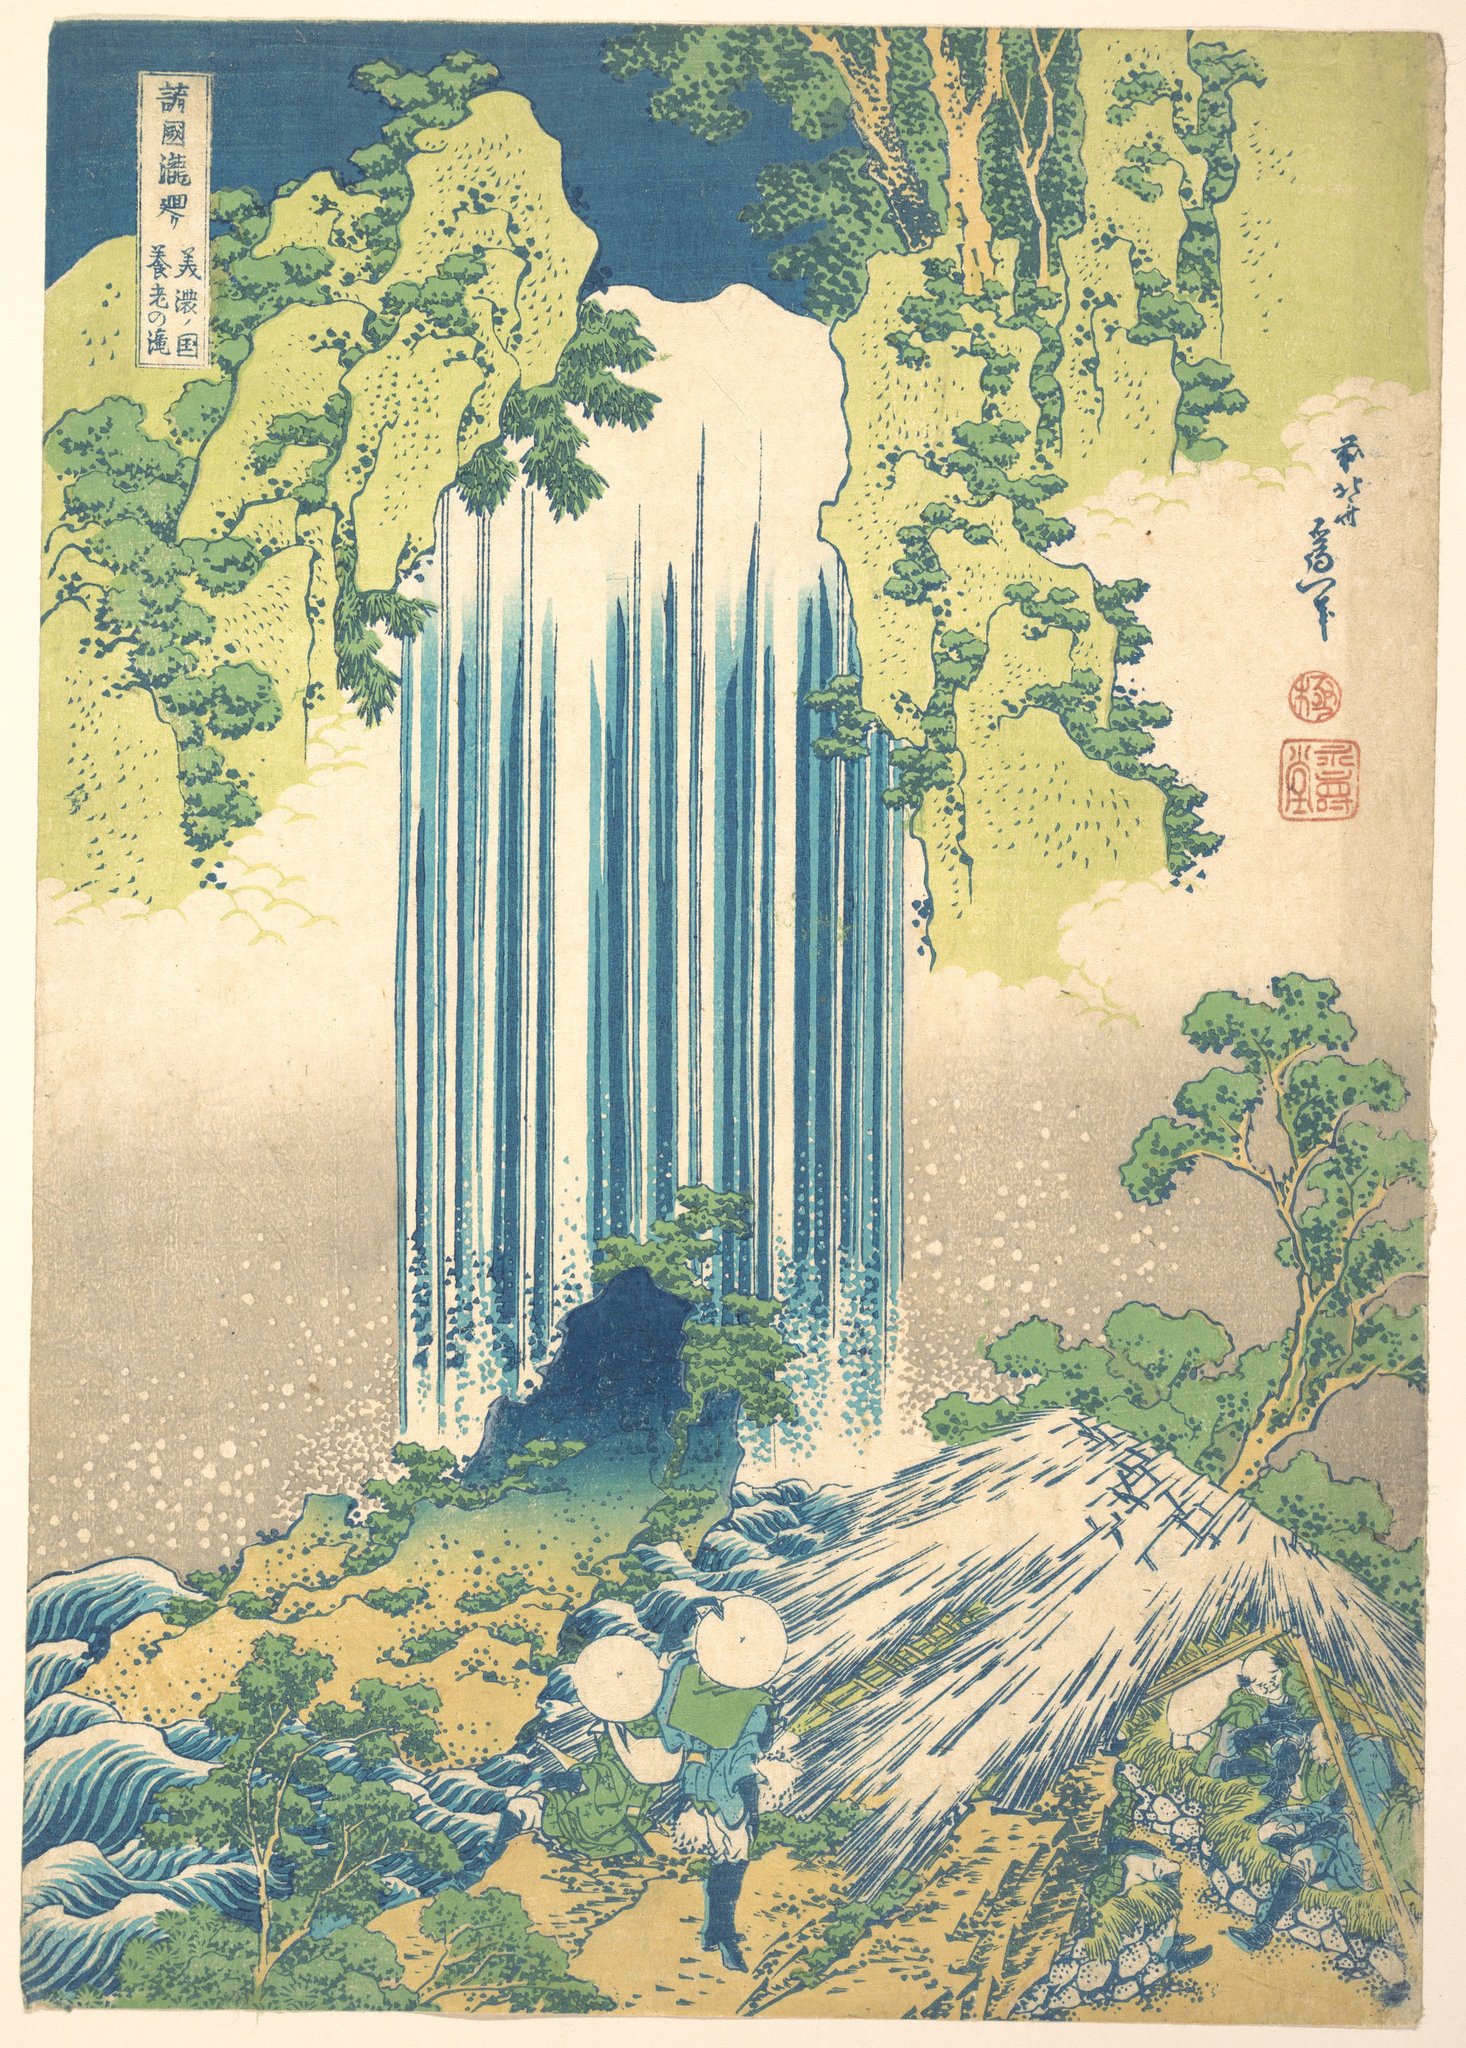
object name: woodblock print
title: Yōrō Waterfall in Mino Province (Mino no Yōrō no taki), from the series A Tour of Waterfalls in Various Provinces (Shokoku taki meguri)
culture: japanese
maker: katsushika hokusai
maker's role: artist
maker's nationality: japanese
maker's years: 1760-1849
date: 1832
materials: ink, paper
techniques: woodblock print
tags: waterfalls